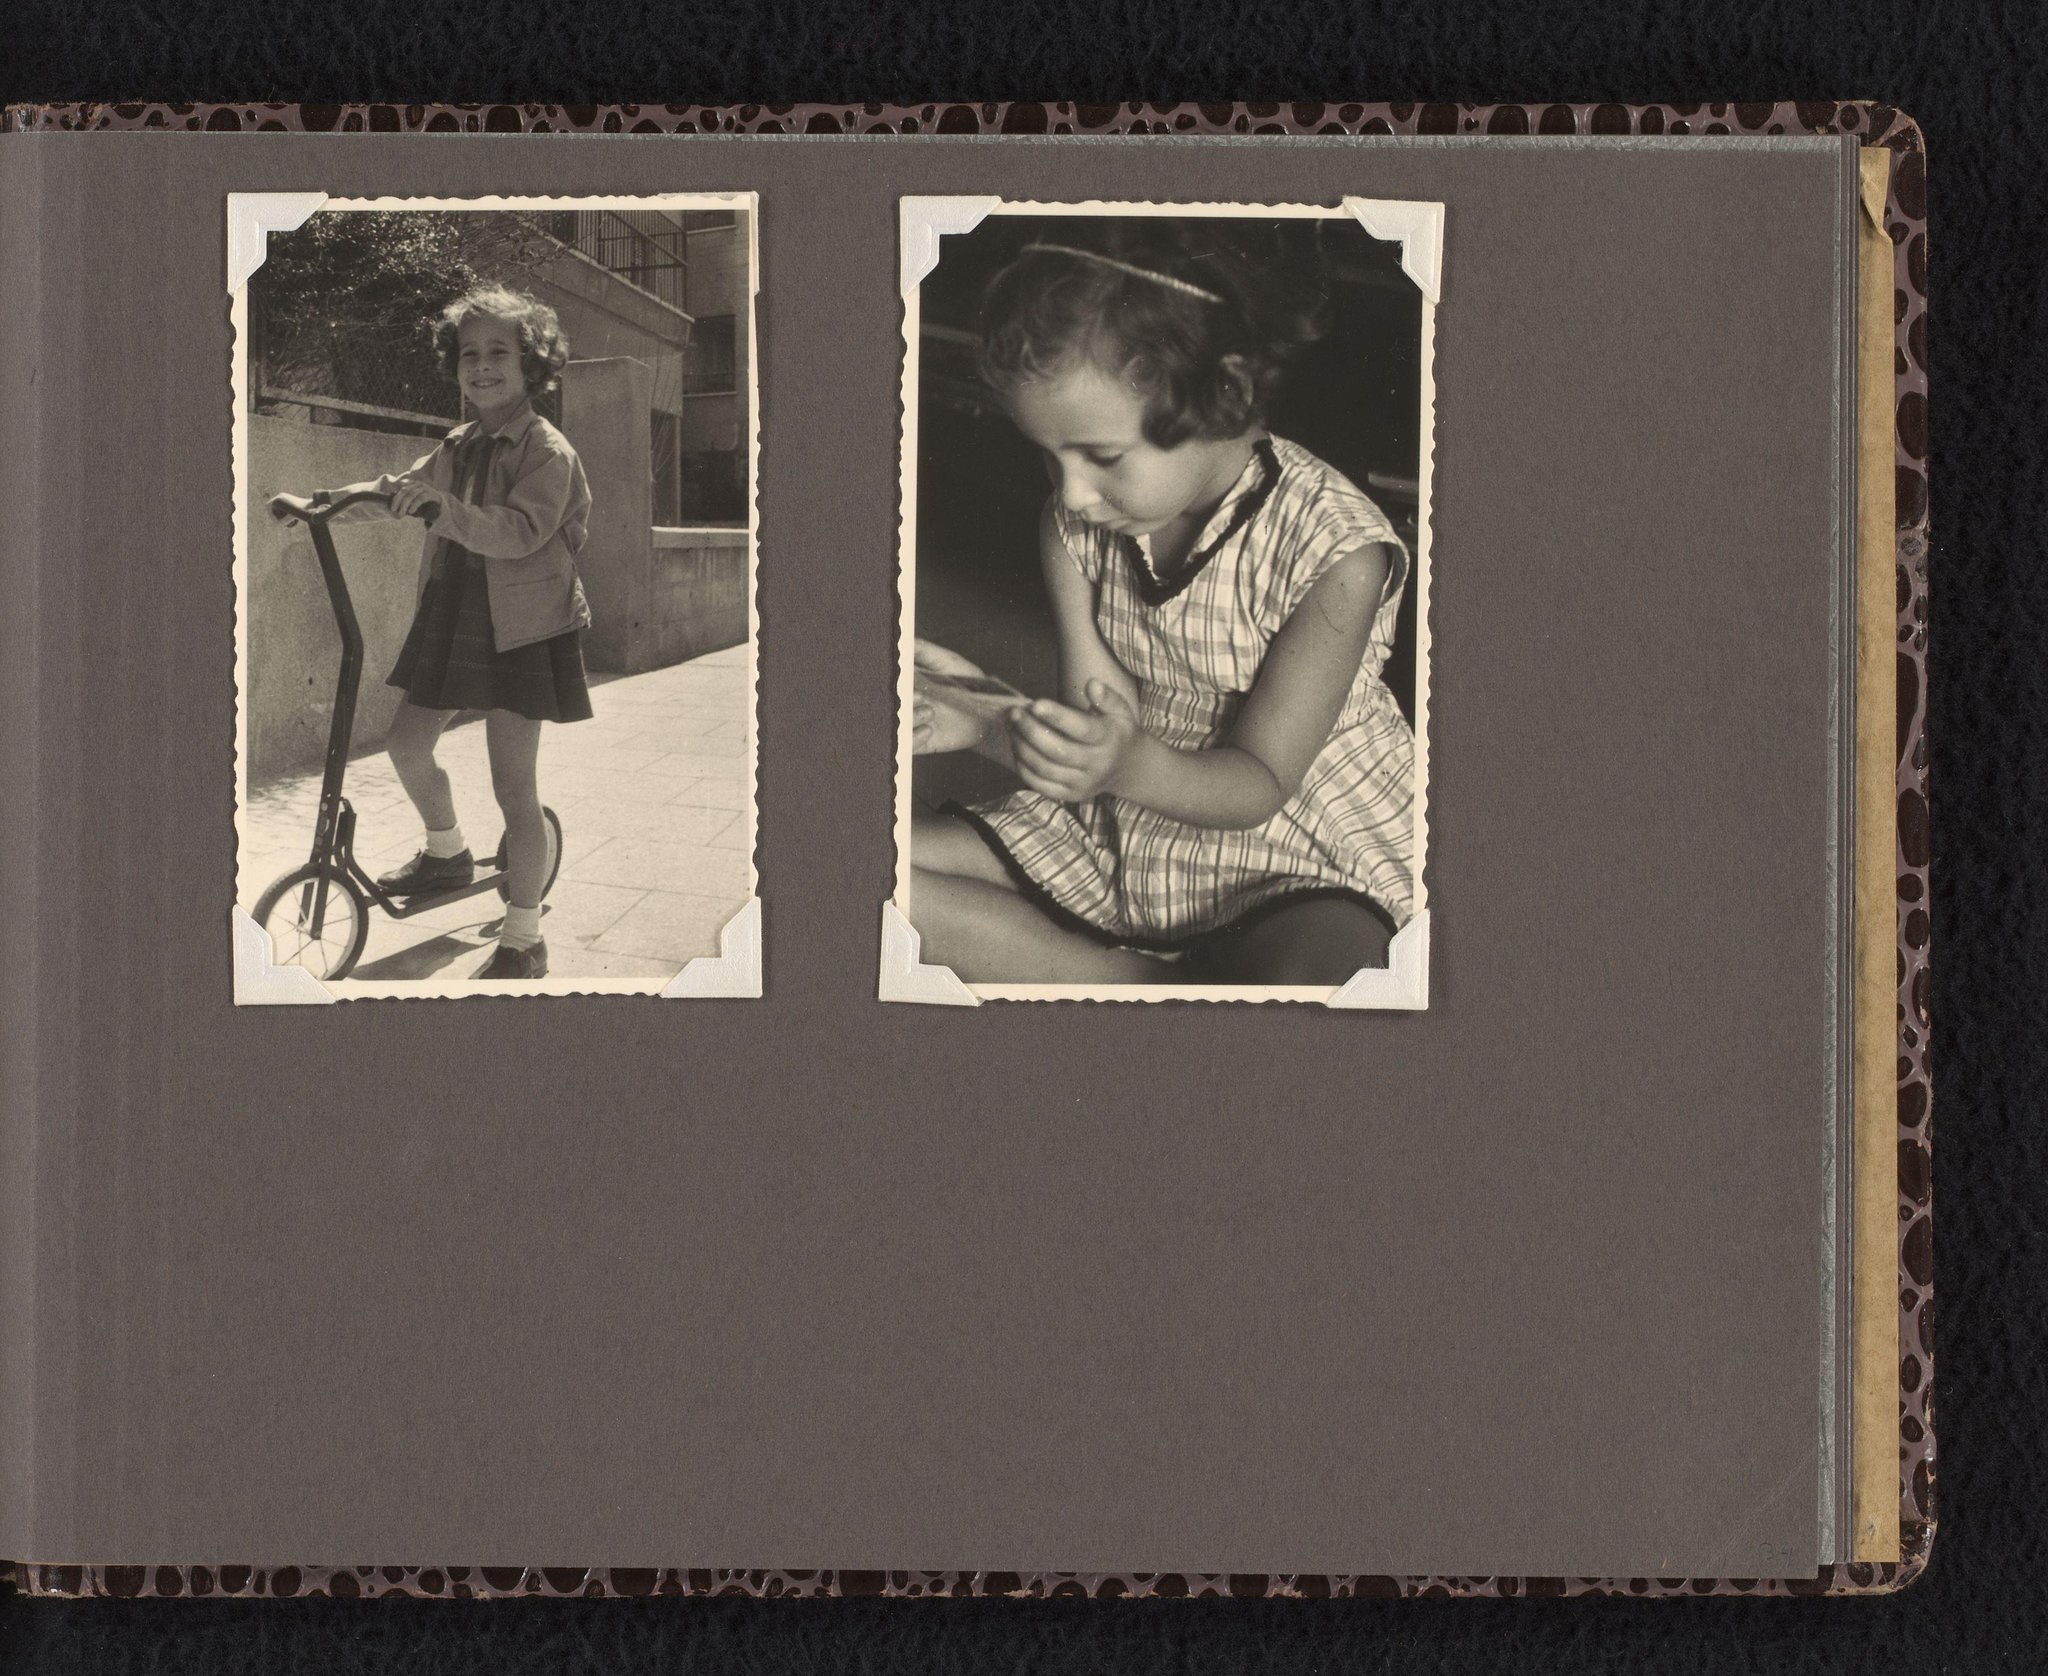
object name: photograph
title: Raja Seligmann 1958, Israël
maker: Anonymous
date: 1958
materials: cardboard, photographic support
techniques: gelatin silver print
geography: tel aviv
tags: historical persons - bb - woman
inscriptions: inscription: ‘Tel-Aviv Summer 1958 "wie vertieft" Raja Seligmann’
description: Blad bevat twee foto's van Raja Seligmann, een vriendin van Isabel, in Tel Aviv, 1958. Uit album half formaat, kunstlederen omslag met koordbinding.